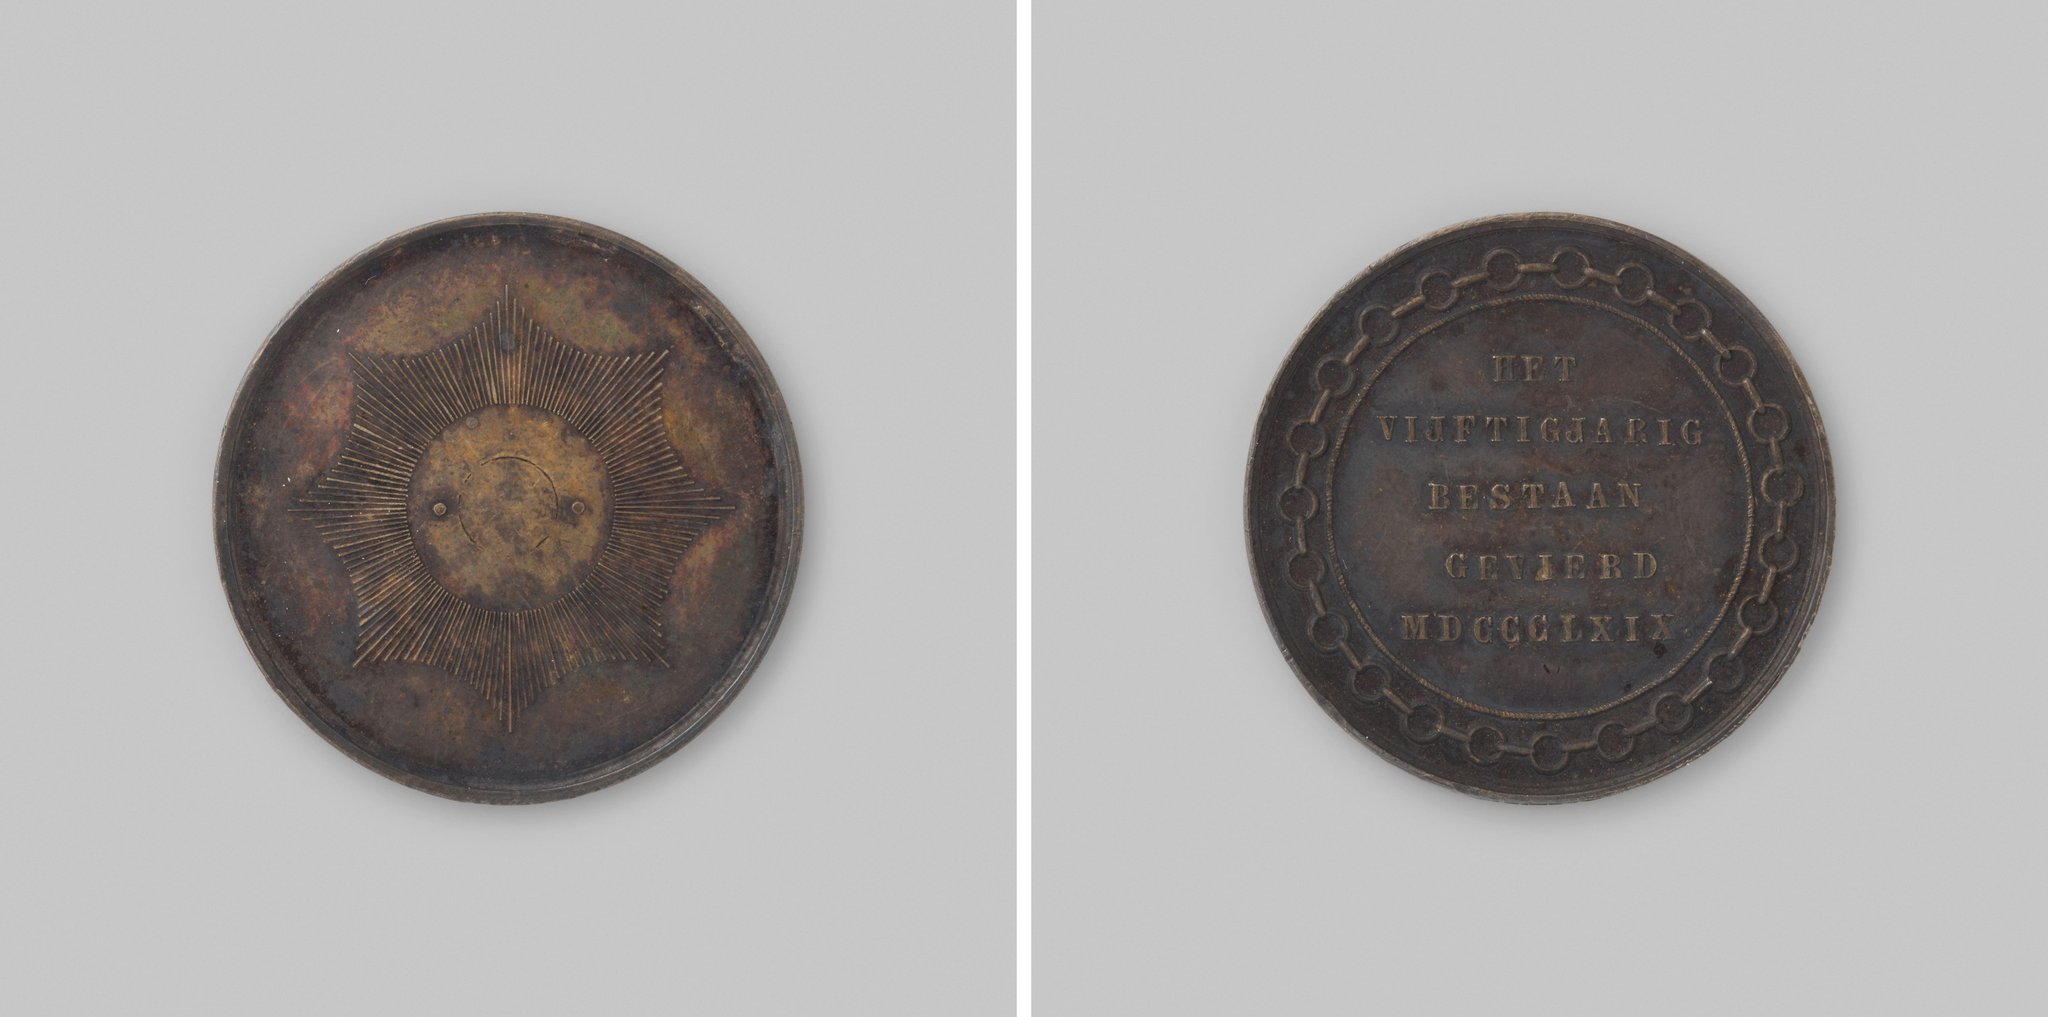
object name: history medal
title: Vijftigjarig bestaan van de graden van Opper- en Uitverkoren Meester van de loge "Groot Oosten der Nederlanden"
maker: david van der kellen (1804-1879)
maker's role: die cutter, draughtsman, print maker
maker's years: 1804-1879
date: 1869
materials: silver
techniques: striking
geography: utrecht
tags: netherlands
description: Zilveren penning. Voorzijde: achtpuntige stralenster met daarbinnen twee punten en cirkel. Keerzijde: opschrift binnen keten van schakels